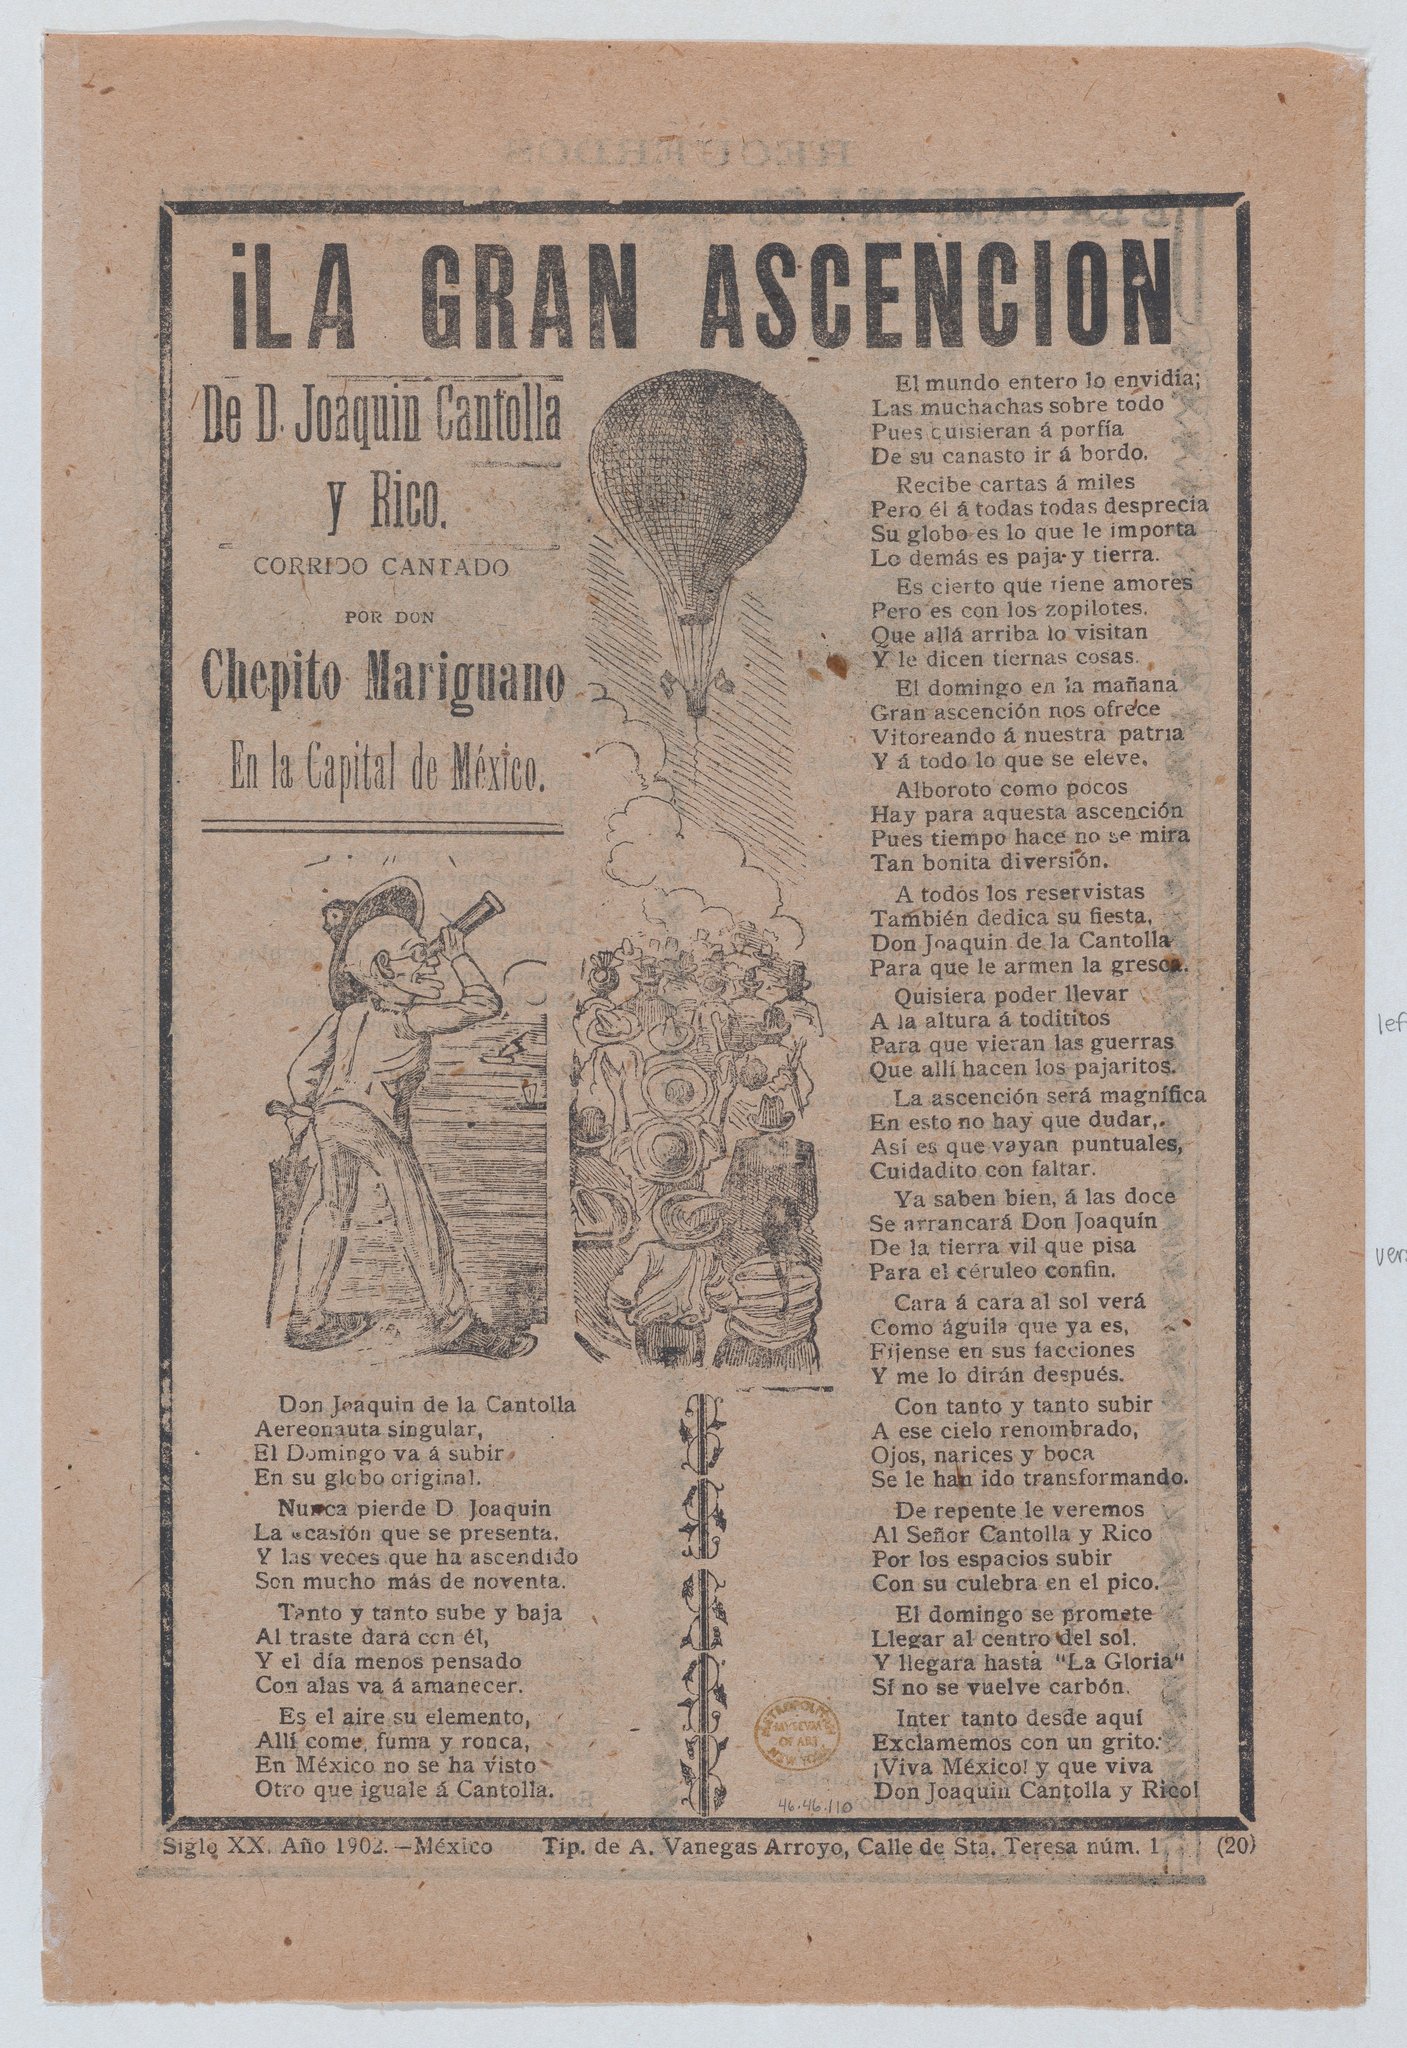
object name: print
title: Broadsheet relating to the adventures of Don Joaquin Cantolla y Rico who travels in a hot air balloon, crowd of people watching him ascend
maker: josé guadalupe posada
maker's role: artist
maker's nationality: mexican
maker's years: 1852-1913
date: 1902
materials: paper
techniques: letterpress, lithography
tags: men,hot air balloons